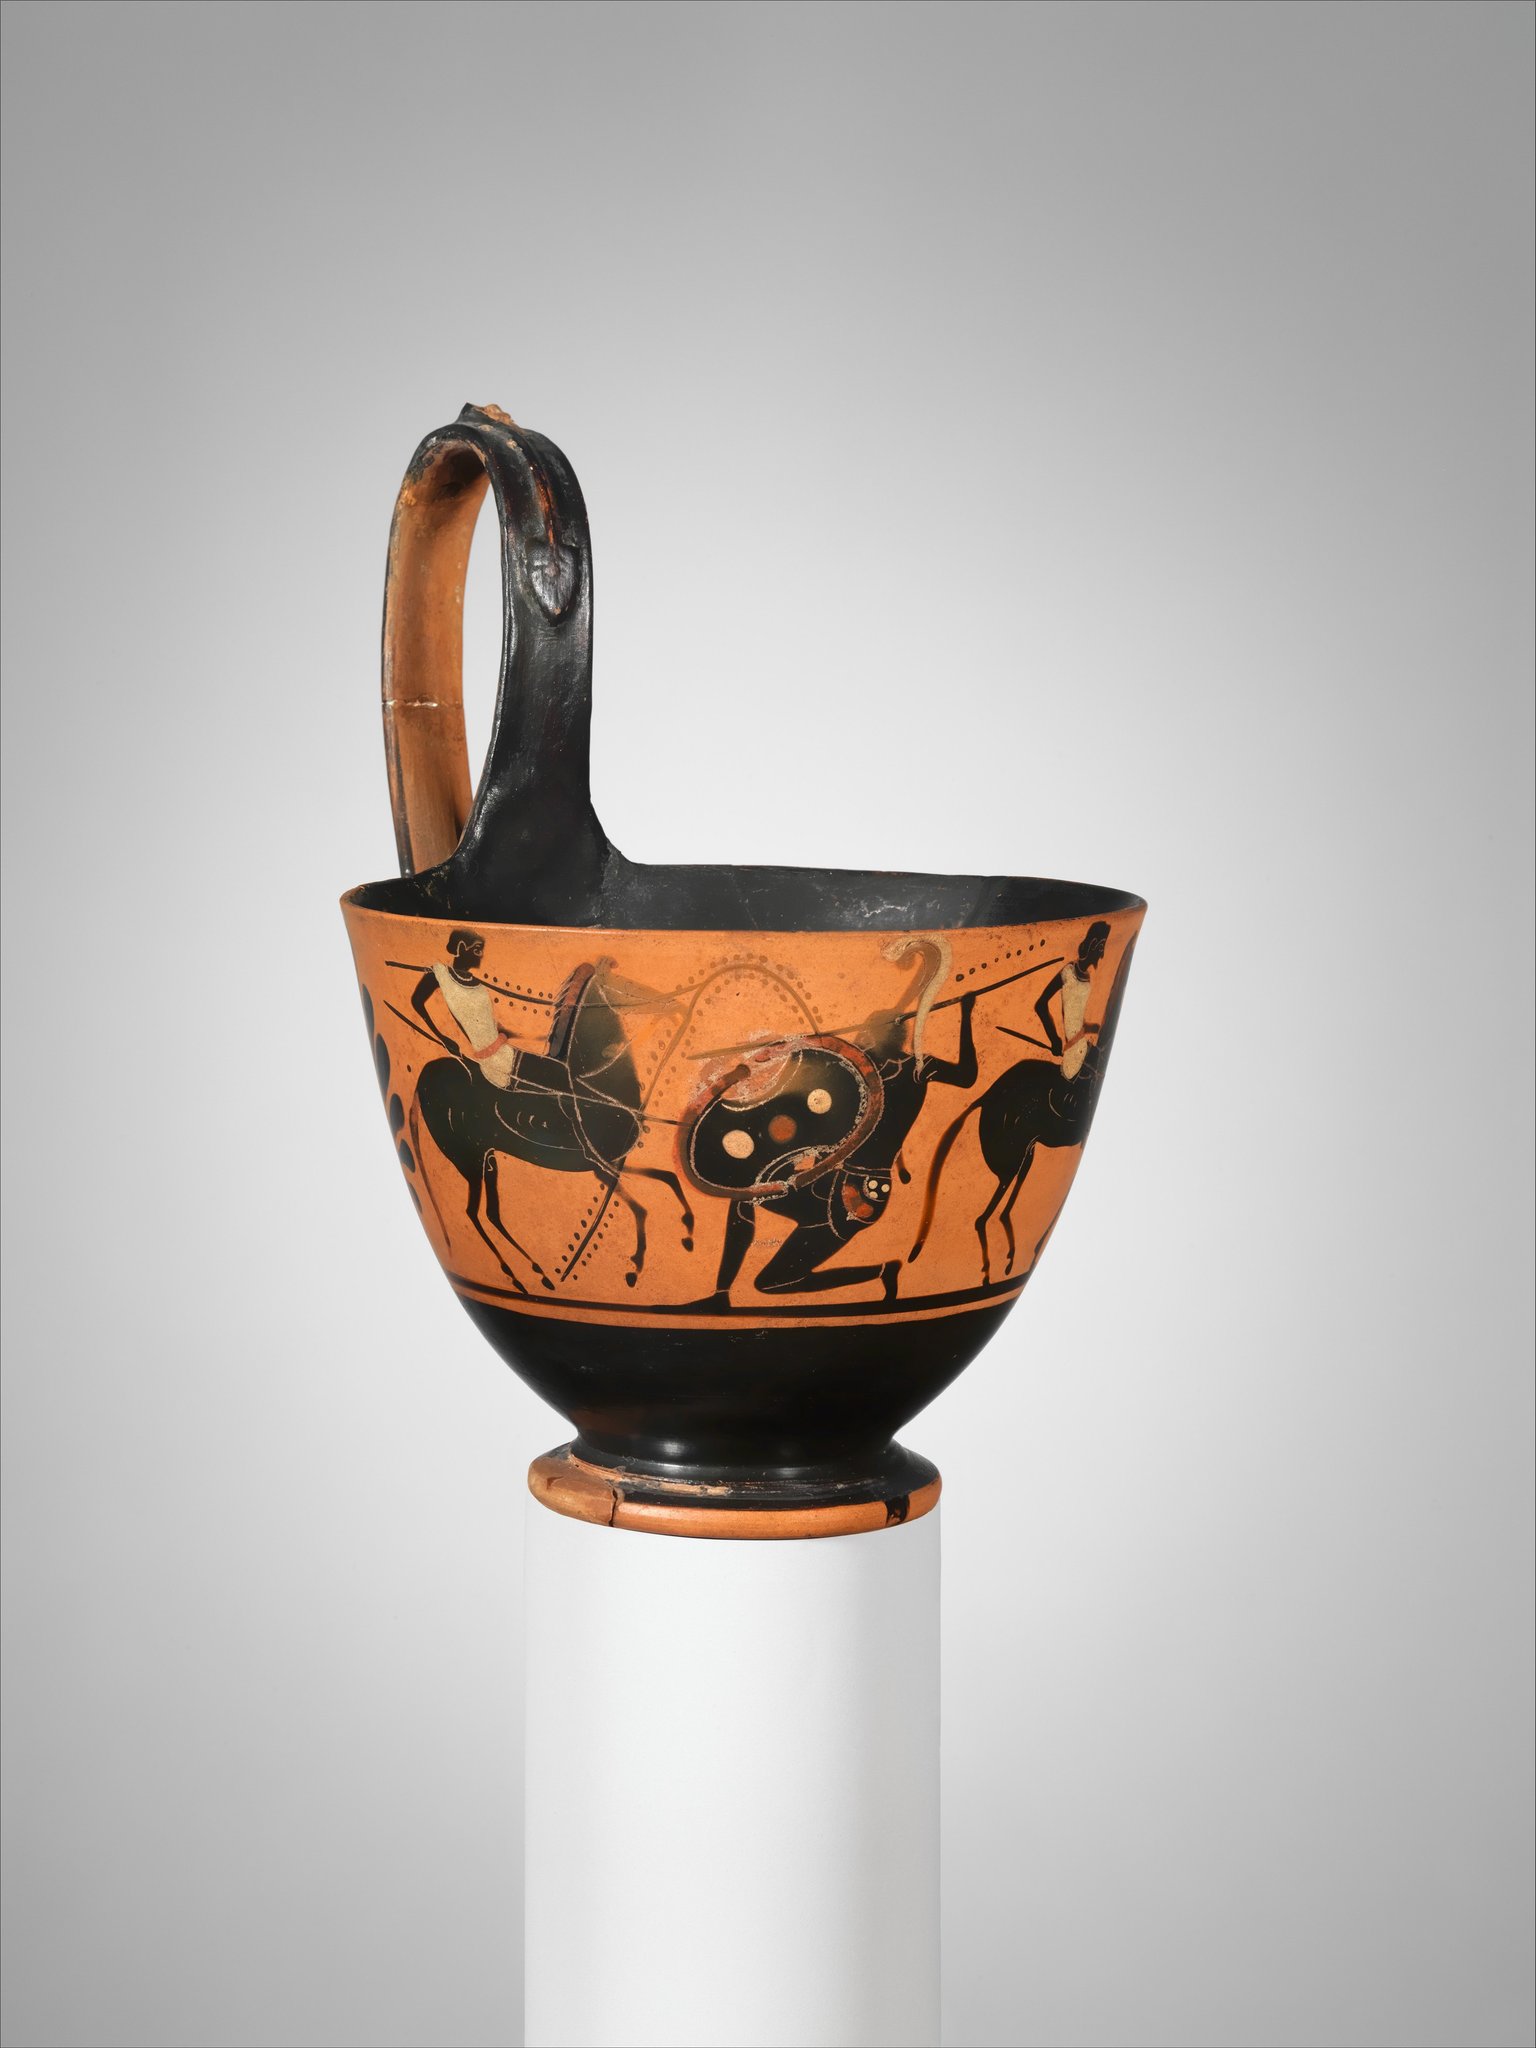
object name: kyathos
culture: greek, attic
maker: philon painter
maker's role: artist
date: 530-500 BCE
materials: terracotta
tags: battles,soldiers,shields,horses